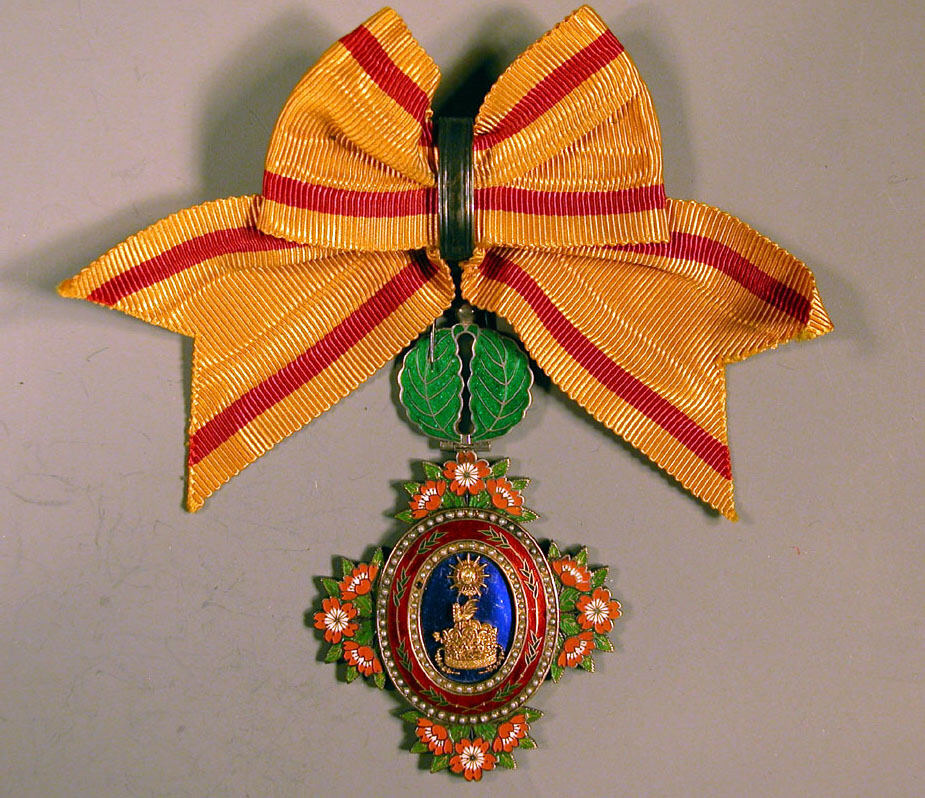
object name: medal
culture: japanese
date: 1867-1900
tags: flowers